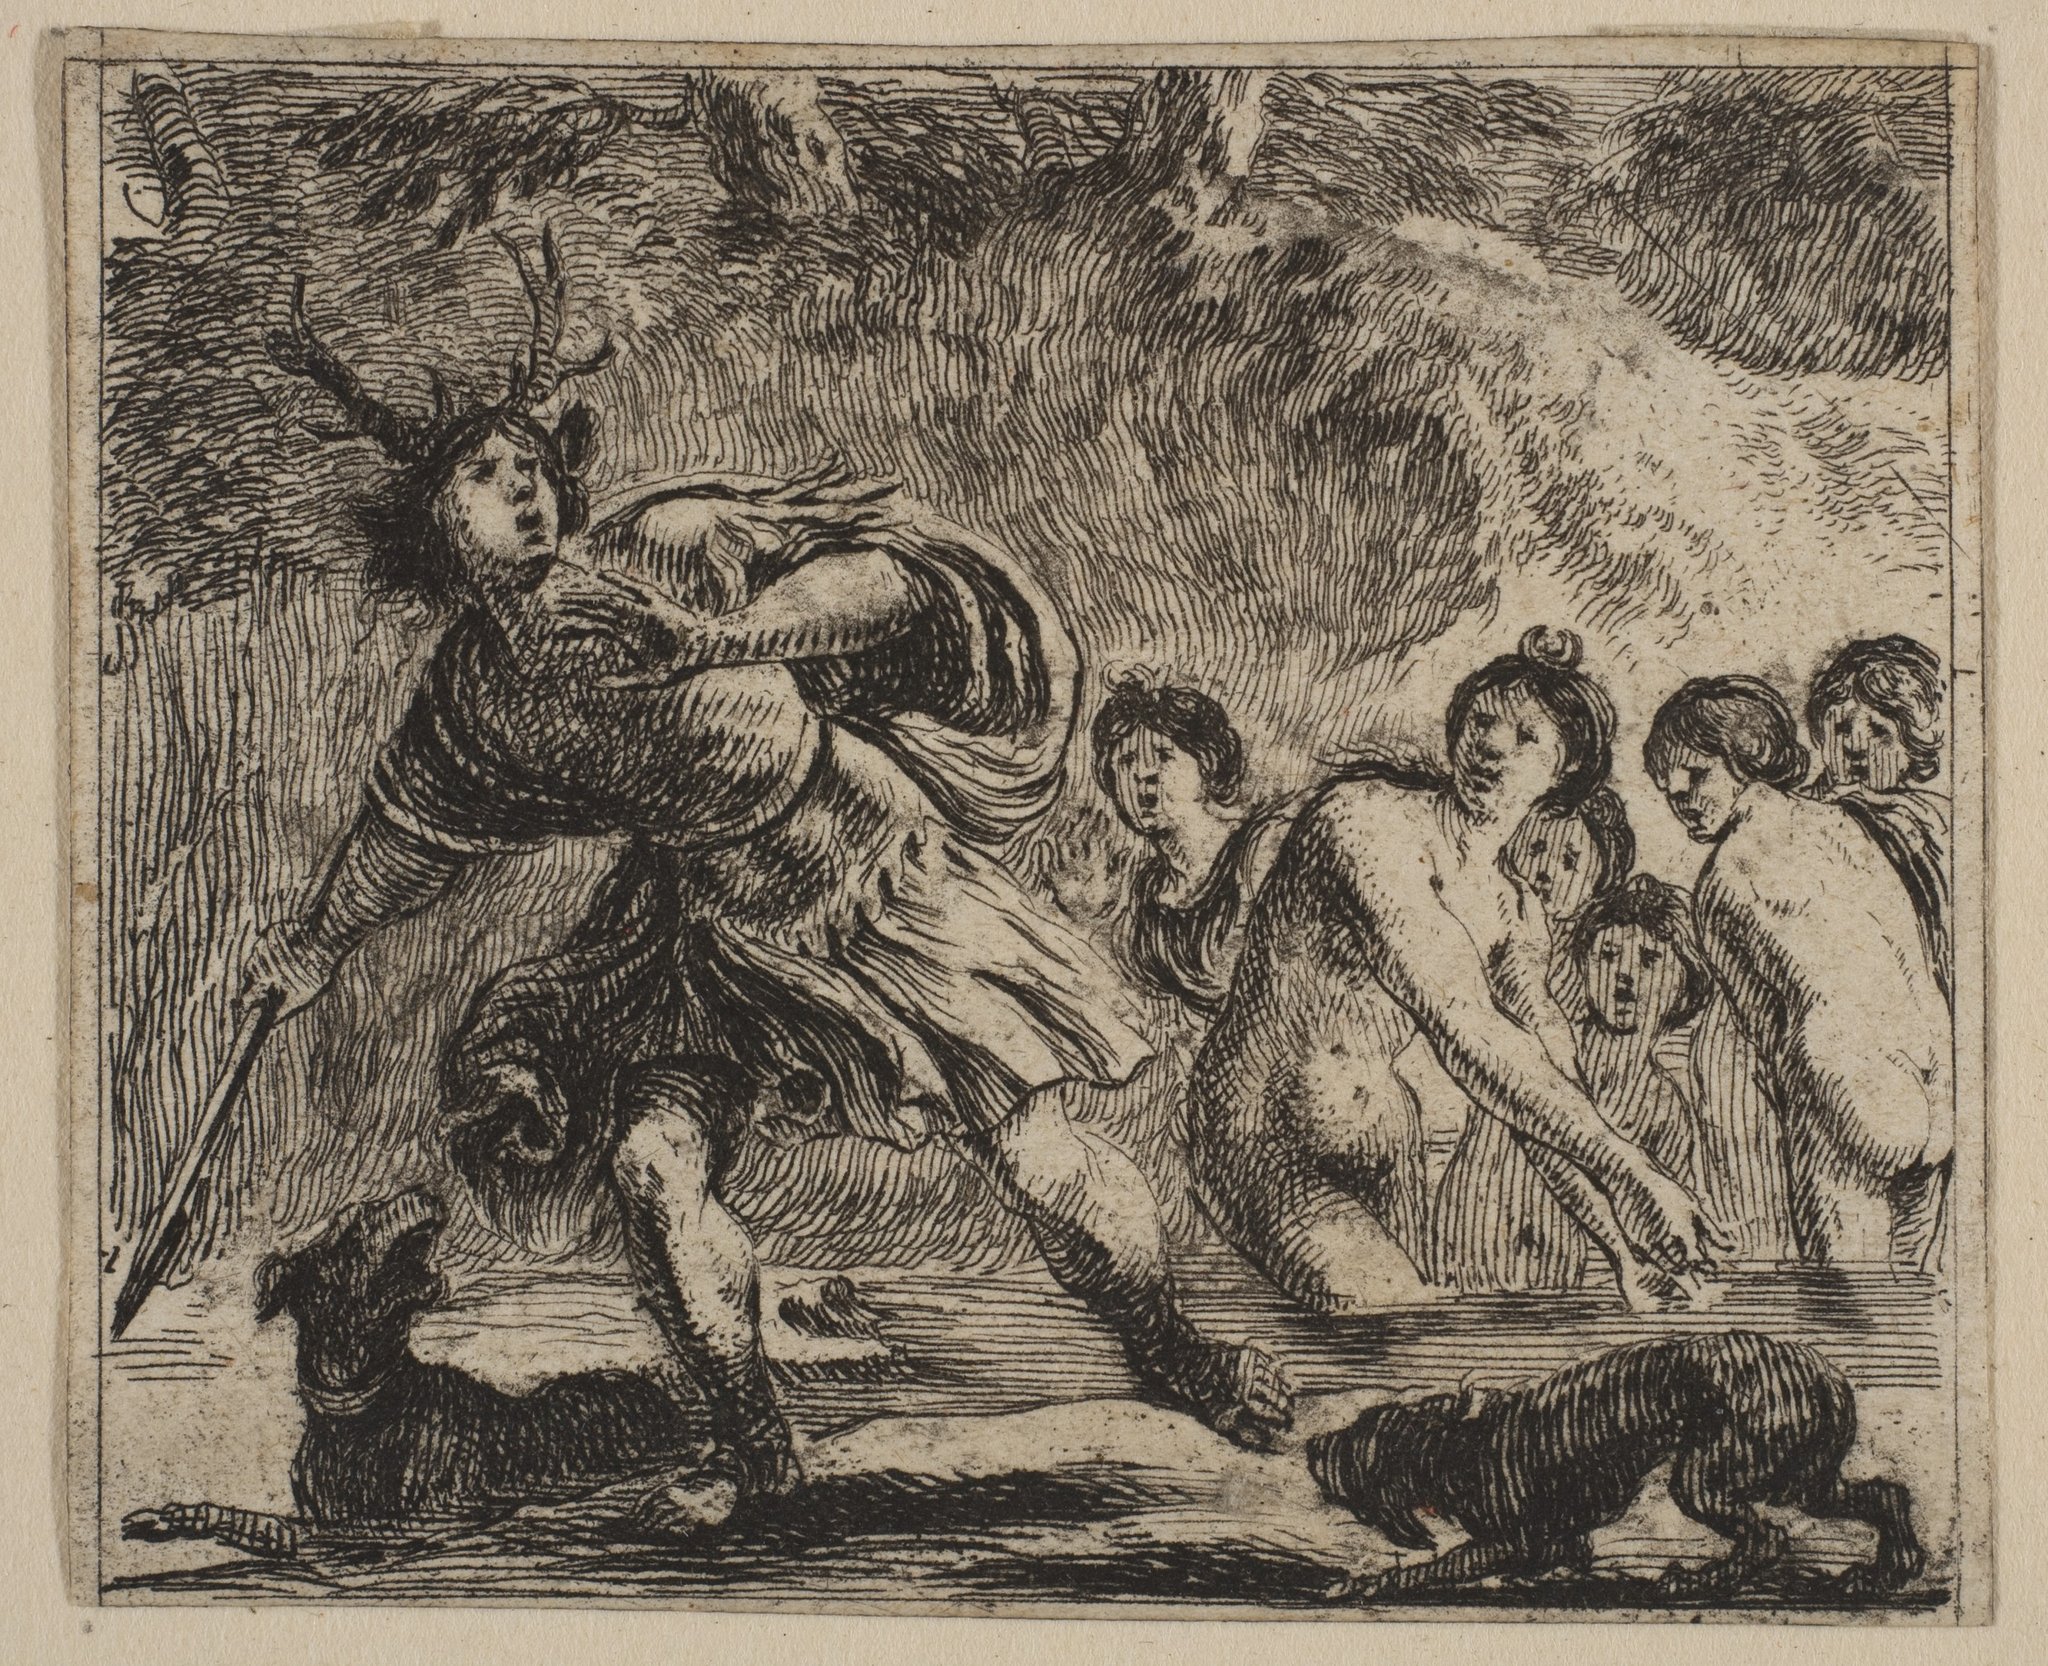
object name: print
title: Acteon, from 'Game of Mythology' (Jeu de la Mythologie)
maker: stefano della bella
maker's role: artist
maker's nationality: italian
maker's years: 1610-1664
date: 1644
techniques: etching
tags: men,female nudes,artemis,actaeon,nymphs,dogs,bathing